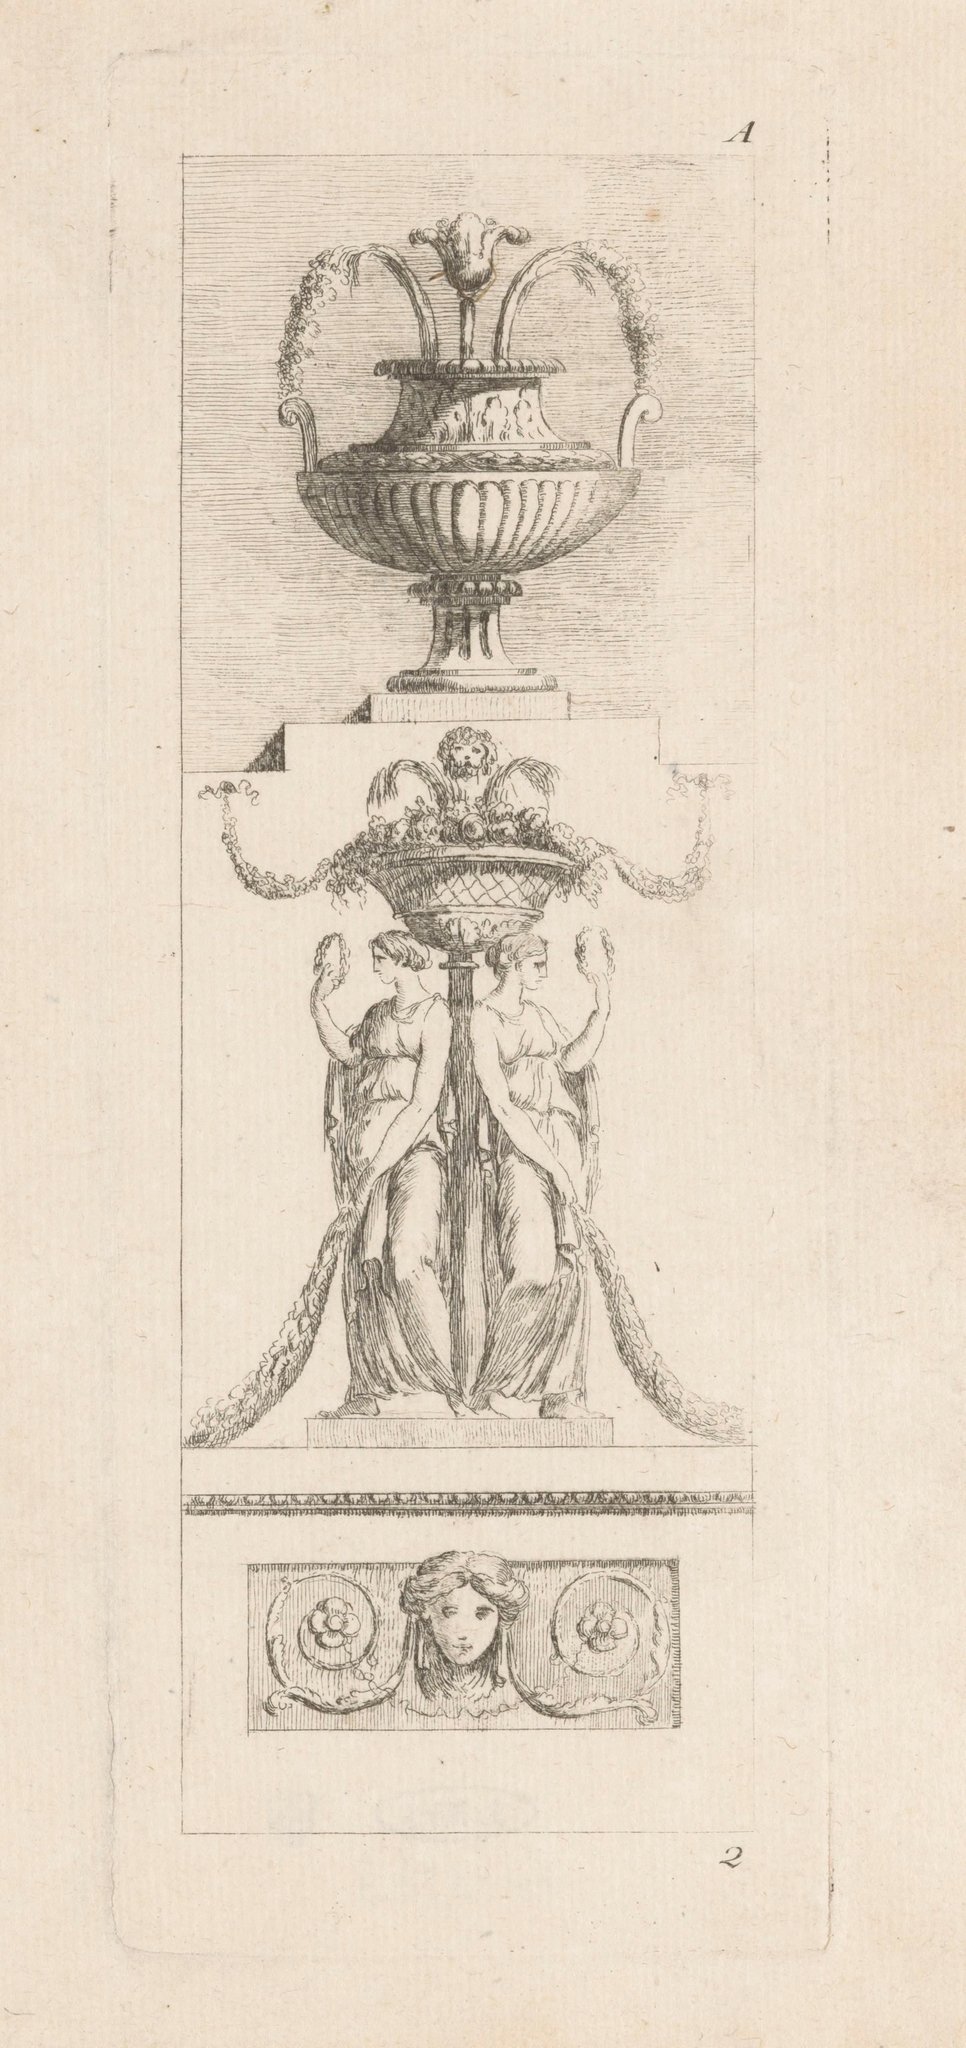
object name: ornament print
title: A Premier Cahier D'Arabesques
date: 1752-1782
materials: paper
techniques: etching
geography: paris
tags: ornament ~ arabesque, vase ~ ornament, standing figure - aa - female human figure, ornamental fountain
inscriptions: collector's mark: Lugt 2228, collector's mark: Lugt 2760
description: Onder een vaas met bloemen staan twee vrouwen met lauwerkransen met een bloemenmand.